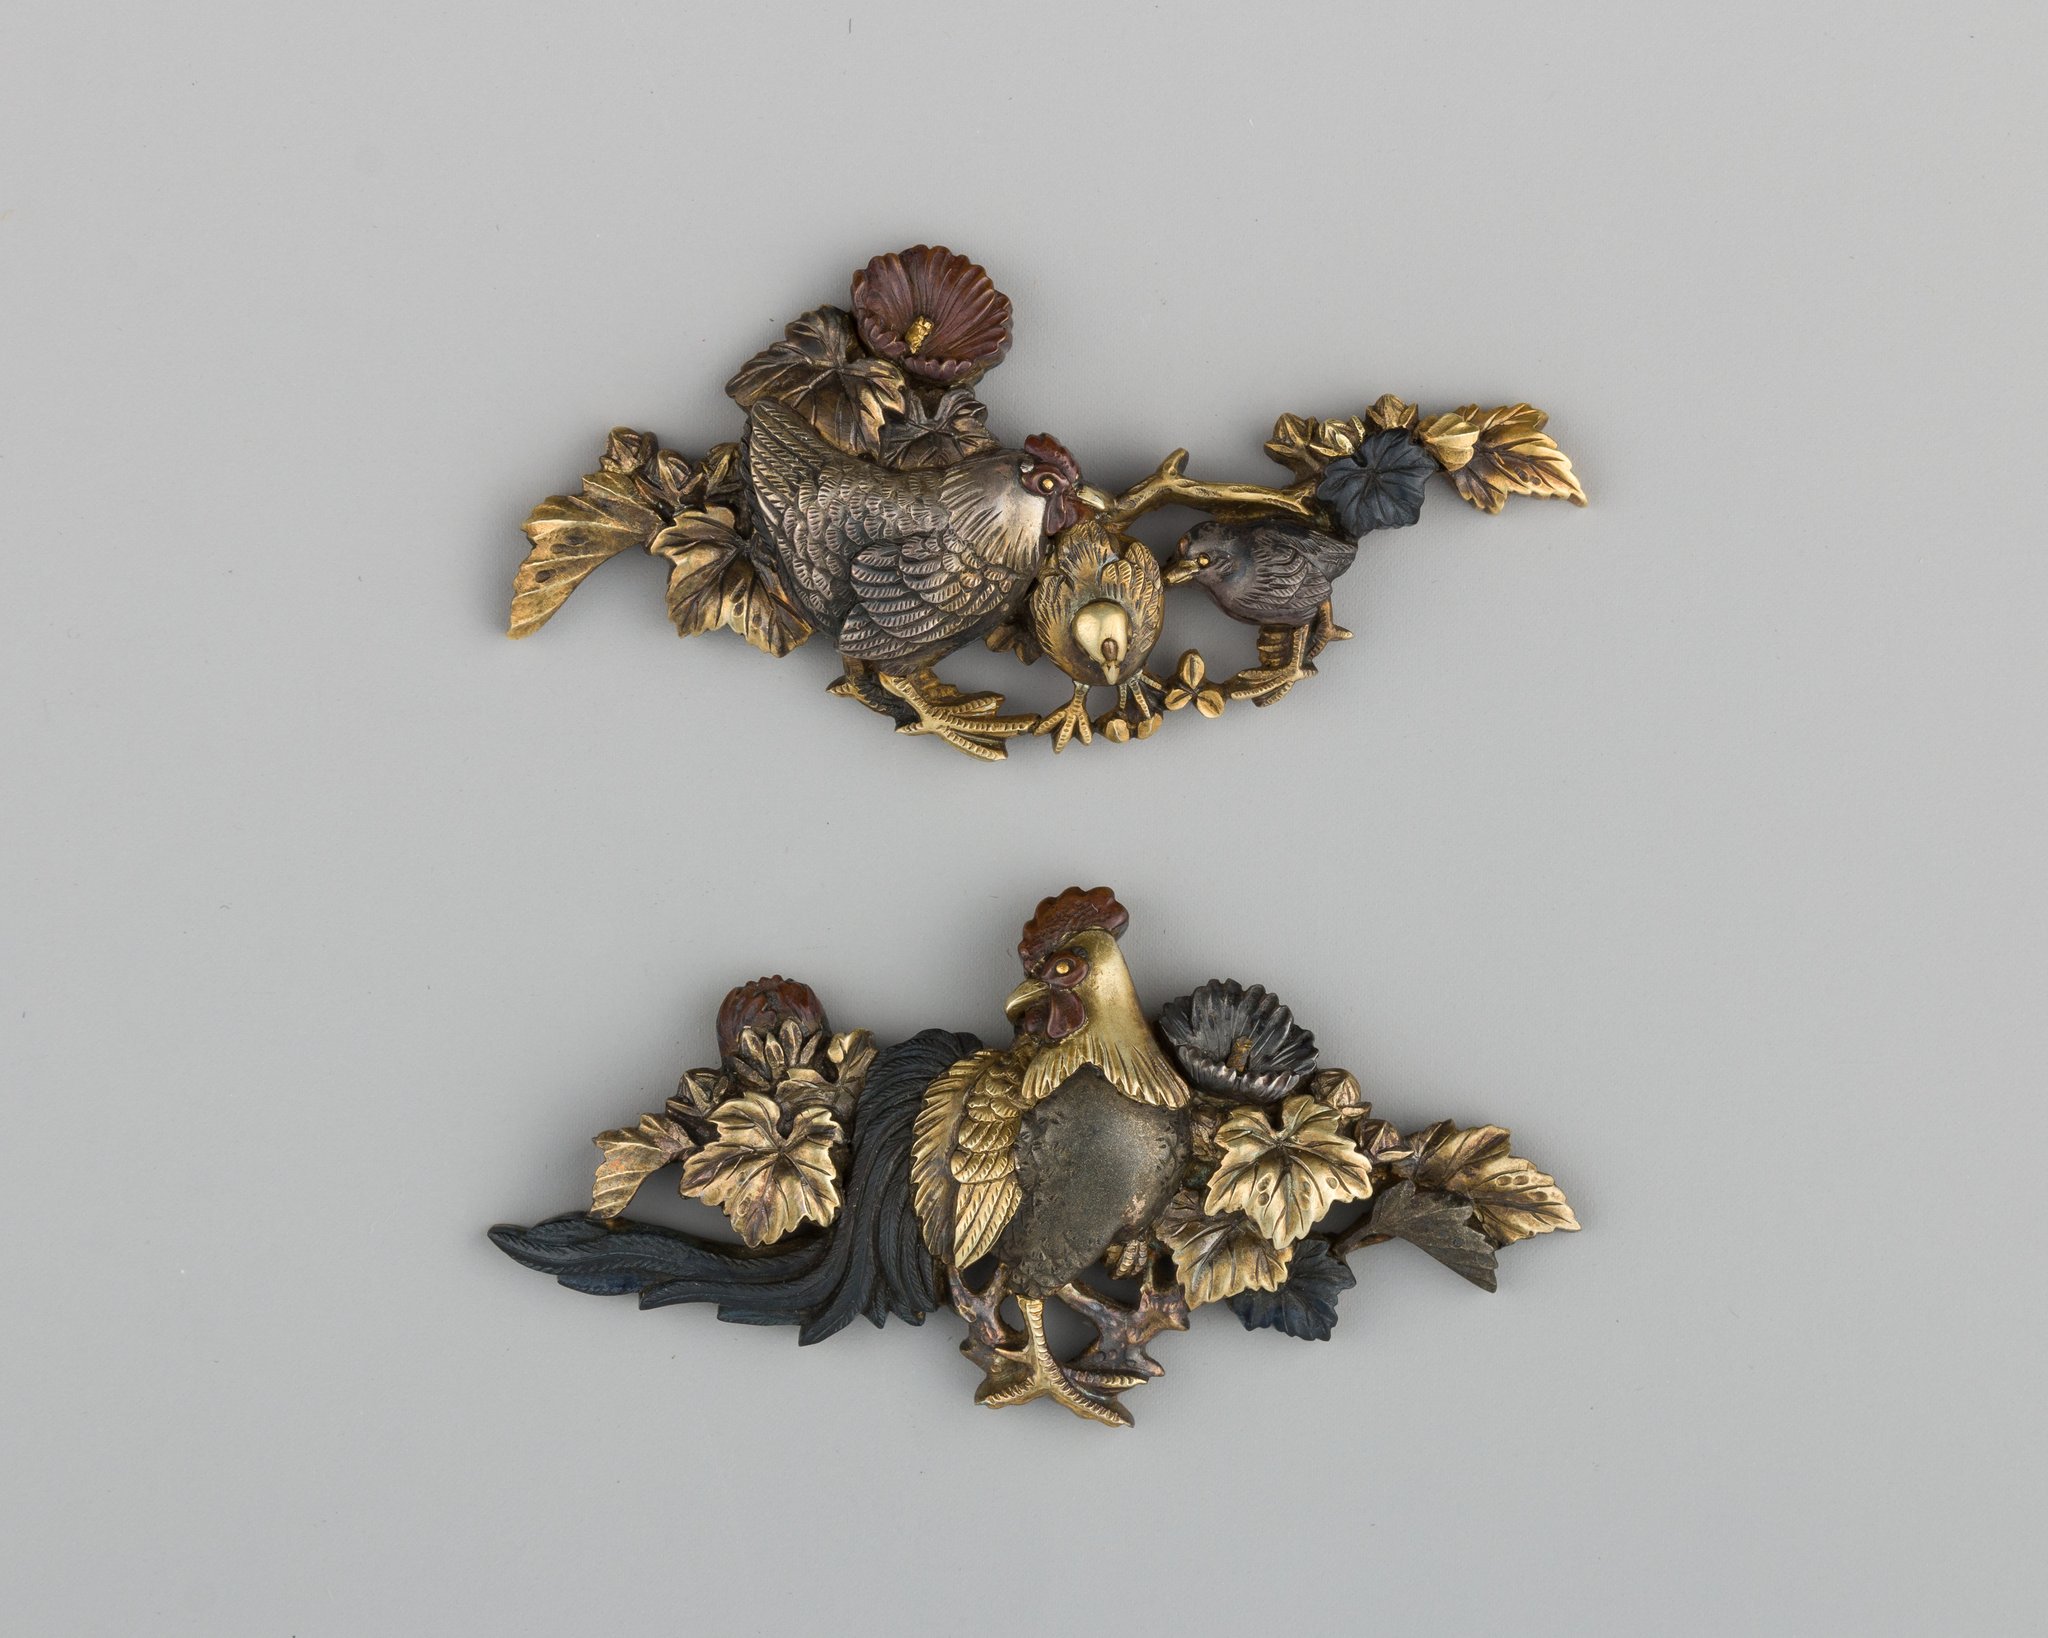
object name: pair of sword grip ornament menuki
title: Pair of Sword-Grip Ornaments (Menuki)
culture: japanese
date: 1701-1800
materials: copper, gold alloy, silver alloy, gold, silver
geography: japan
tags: birds,leaves